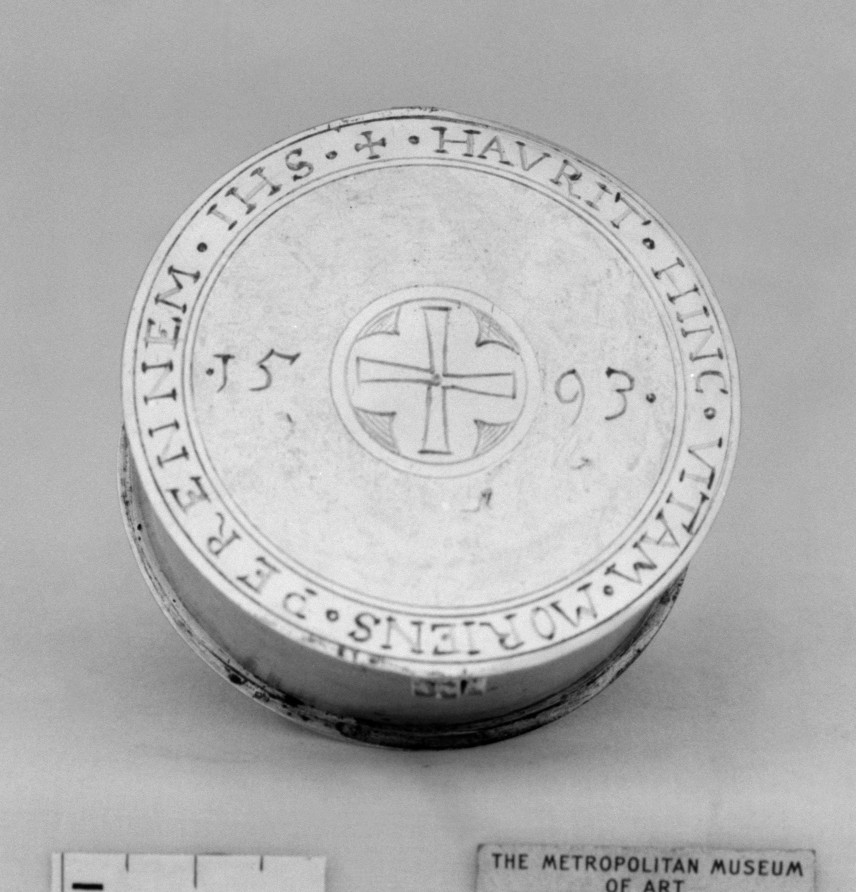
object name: pyx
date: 1501-1600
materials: silver, silver gilt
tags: cross